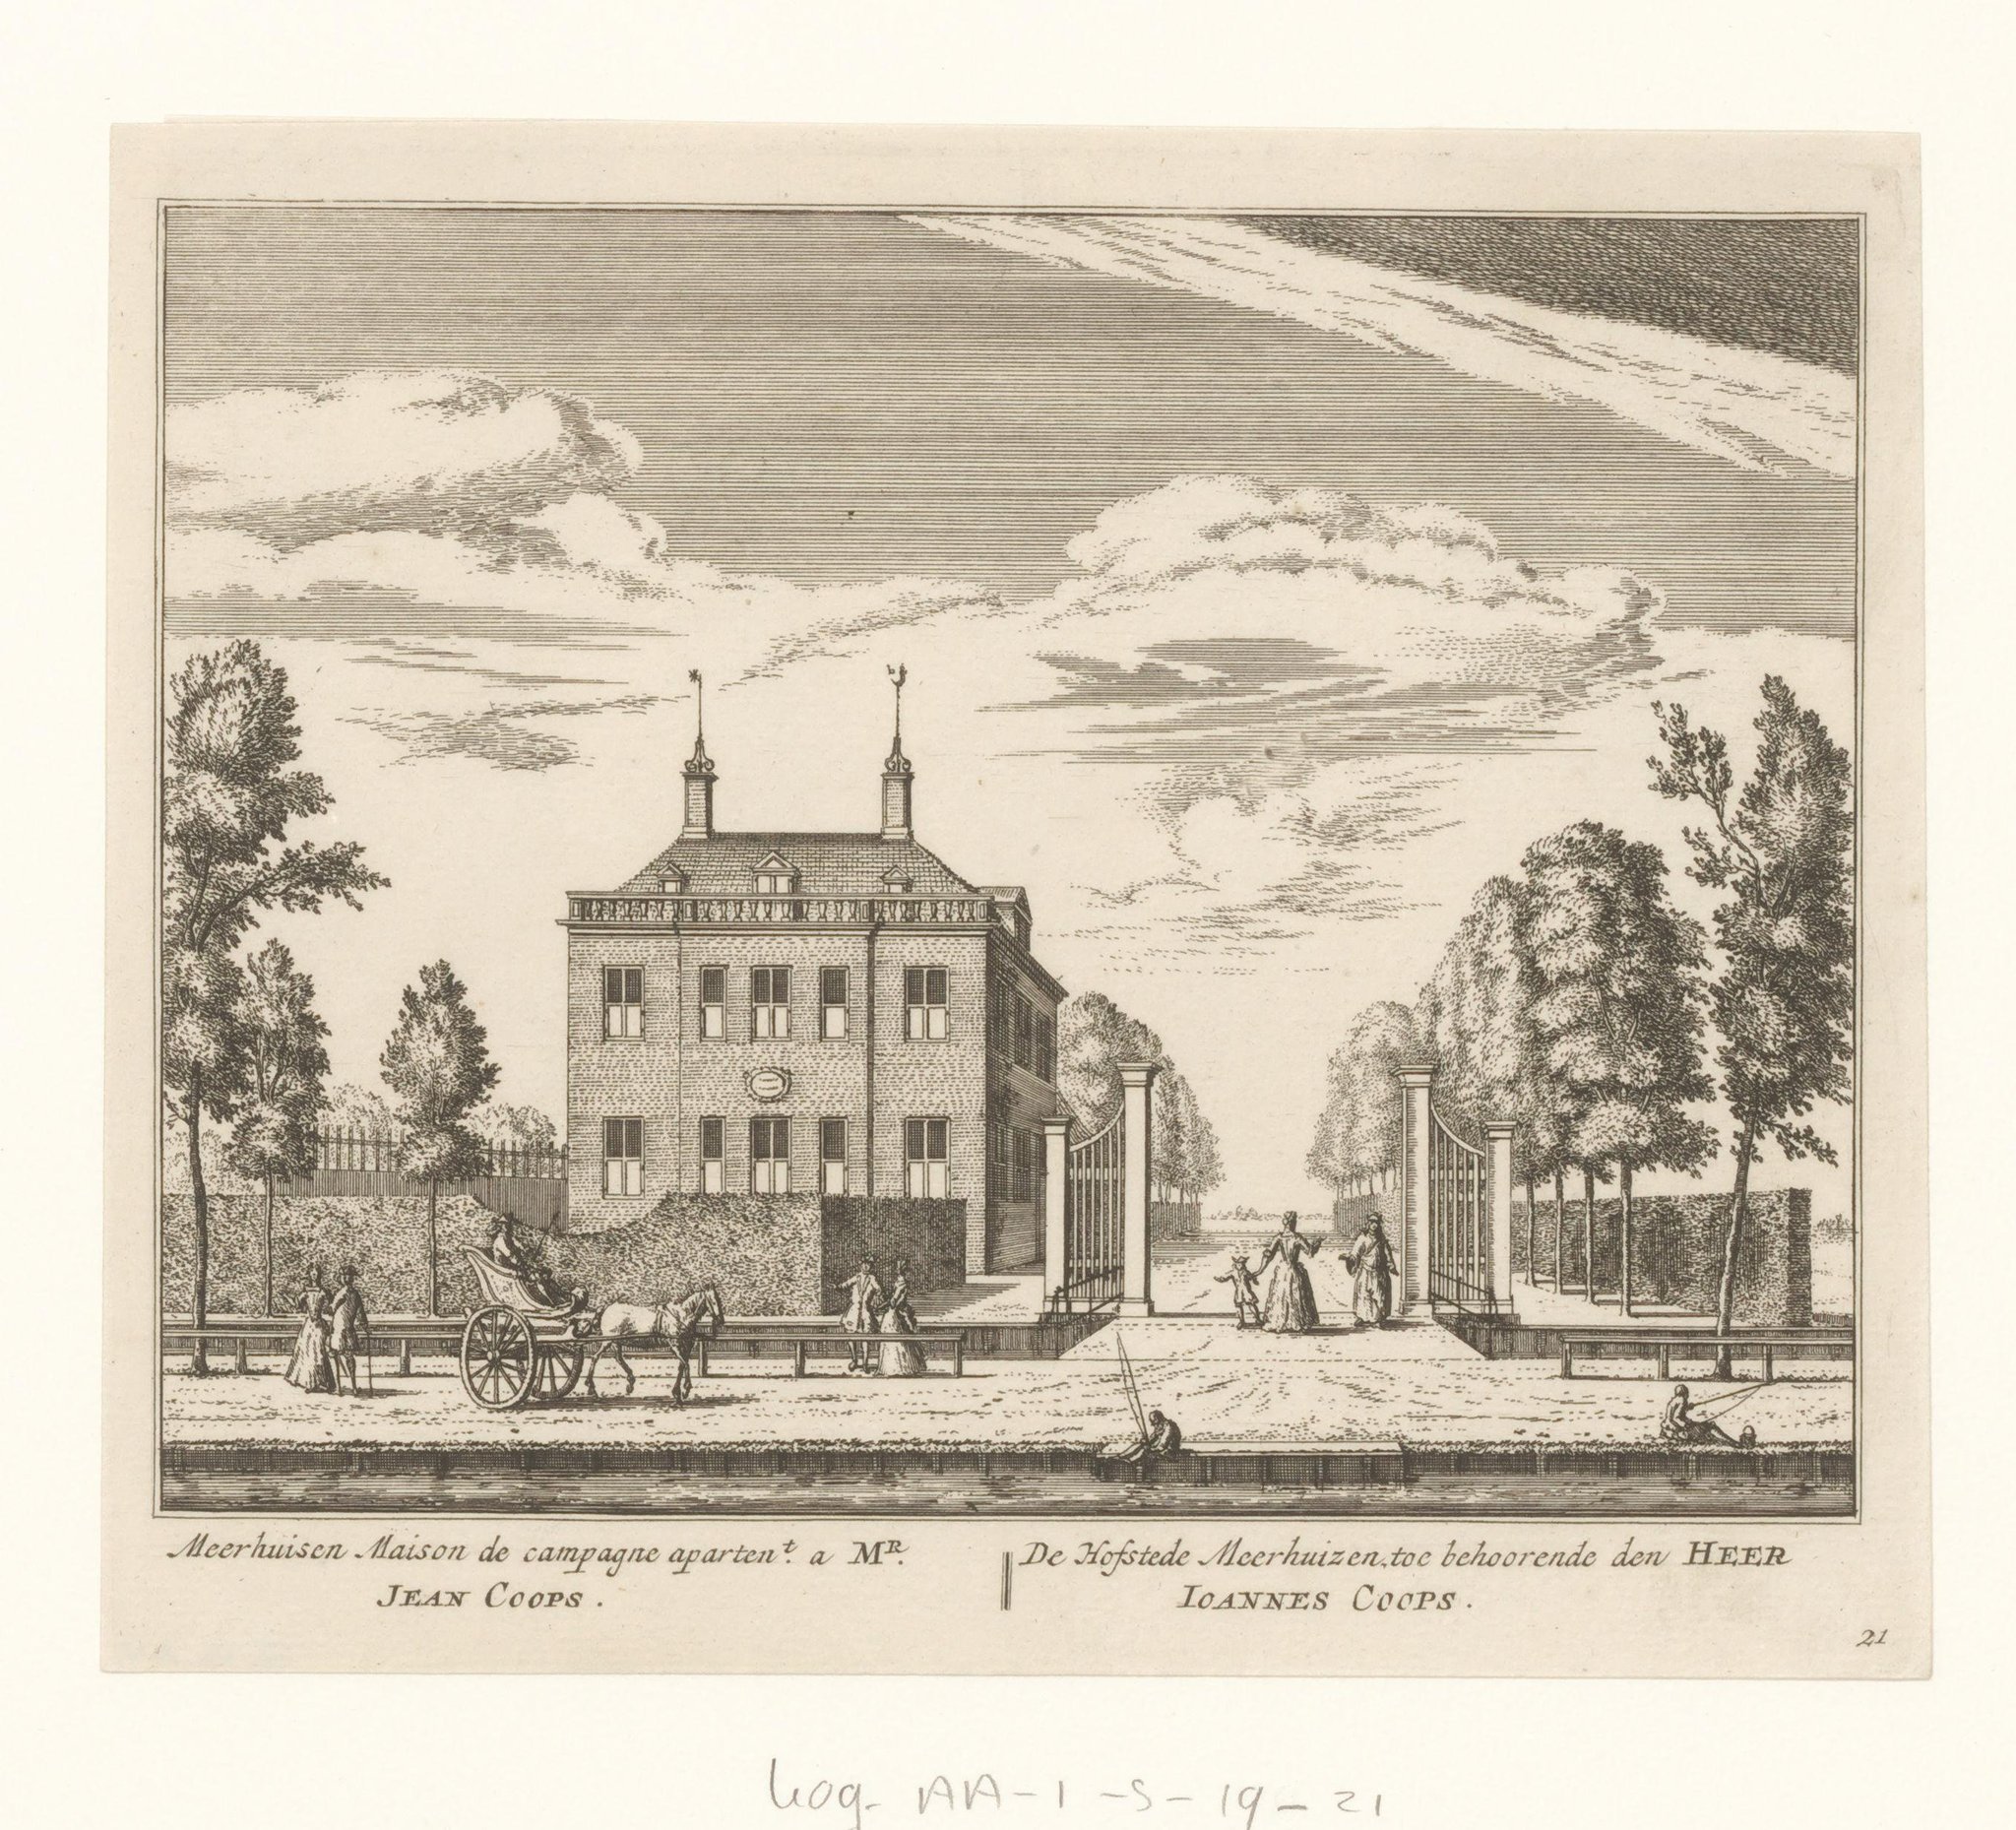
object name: print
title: Gezicht op buitenplaats Meerhuizen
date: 1730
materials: paper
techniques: etching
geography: amsterdam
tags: city-view in general; 'veduta', river, rural housing, e.g. country-house, villa, cottage, gate, entrance, angling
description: Prent waarschijnlijk uit: Tijsens, Gijsbert. Hollands Arcadia, of de vermaarde rivier den Amstel (...) naar 't léven getekend en in 't ligt gebragt door Abraham Rademaker (...). Amsterdam: Leonardus Schenk, 1730.